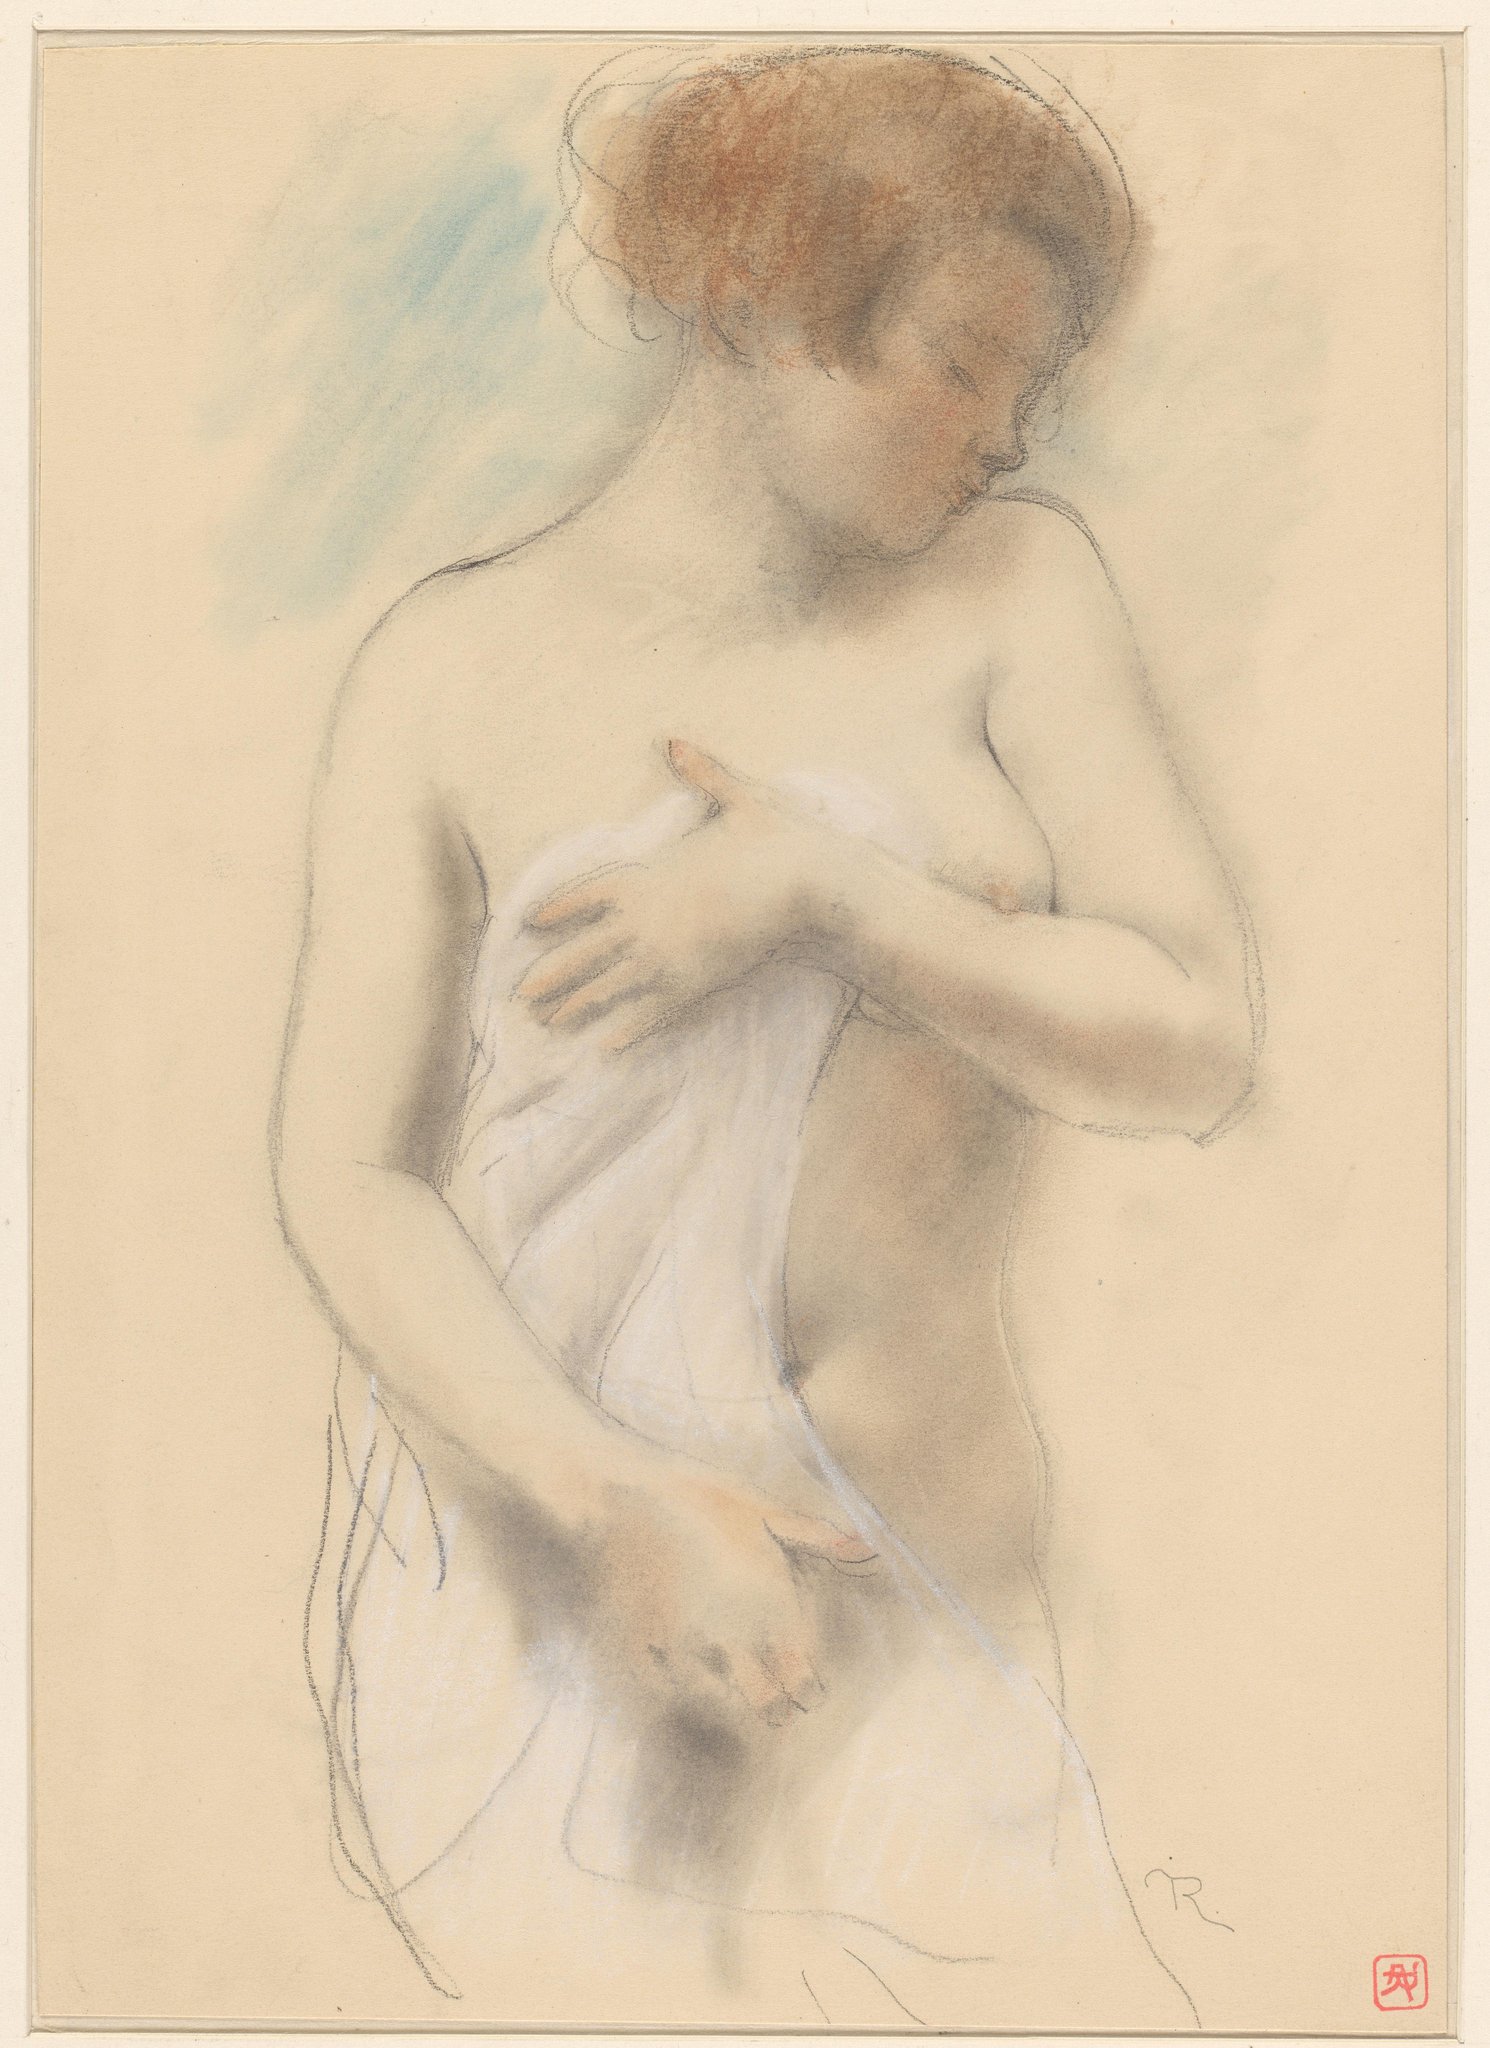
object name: drawing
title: Staande naakte vrouw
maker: armand rassenfosse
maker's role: draughtsman, painter, print maker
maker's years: 1862-1934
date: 1872-1934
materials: paper, pastel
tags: standing figure - aa - female human figure